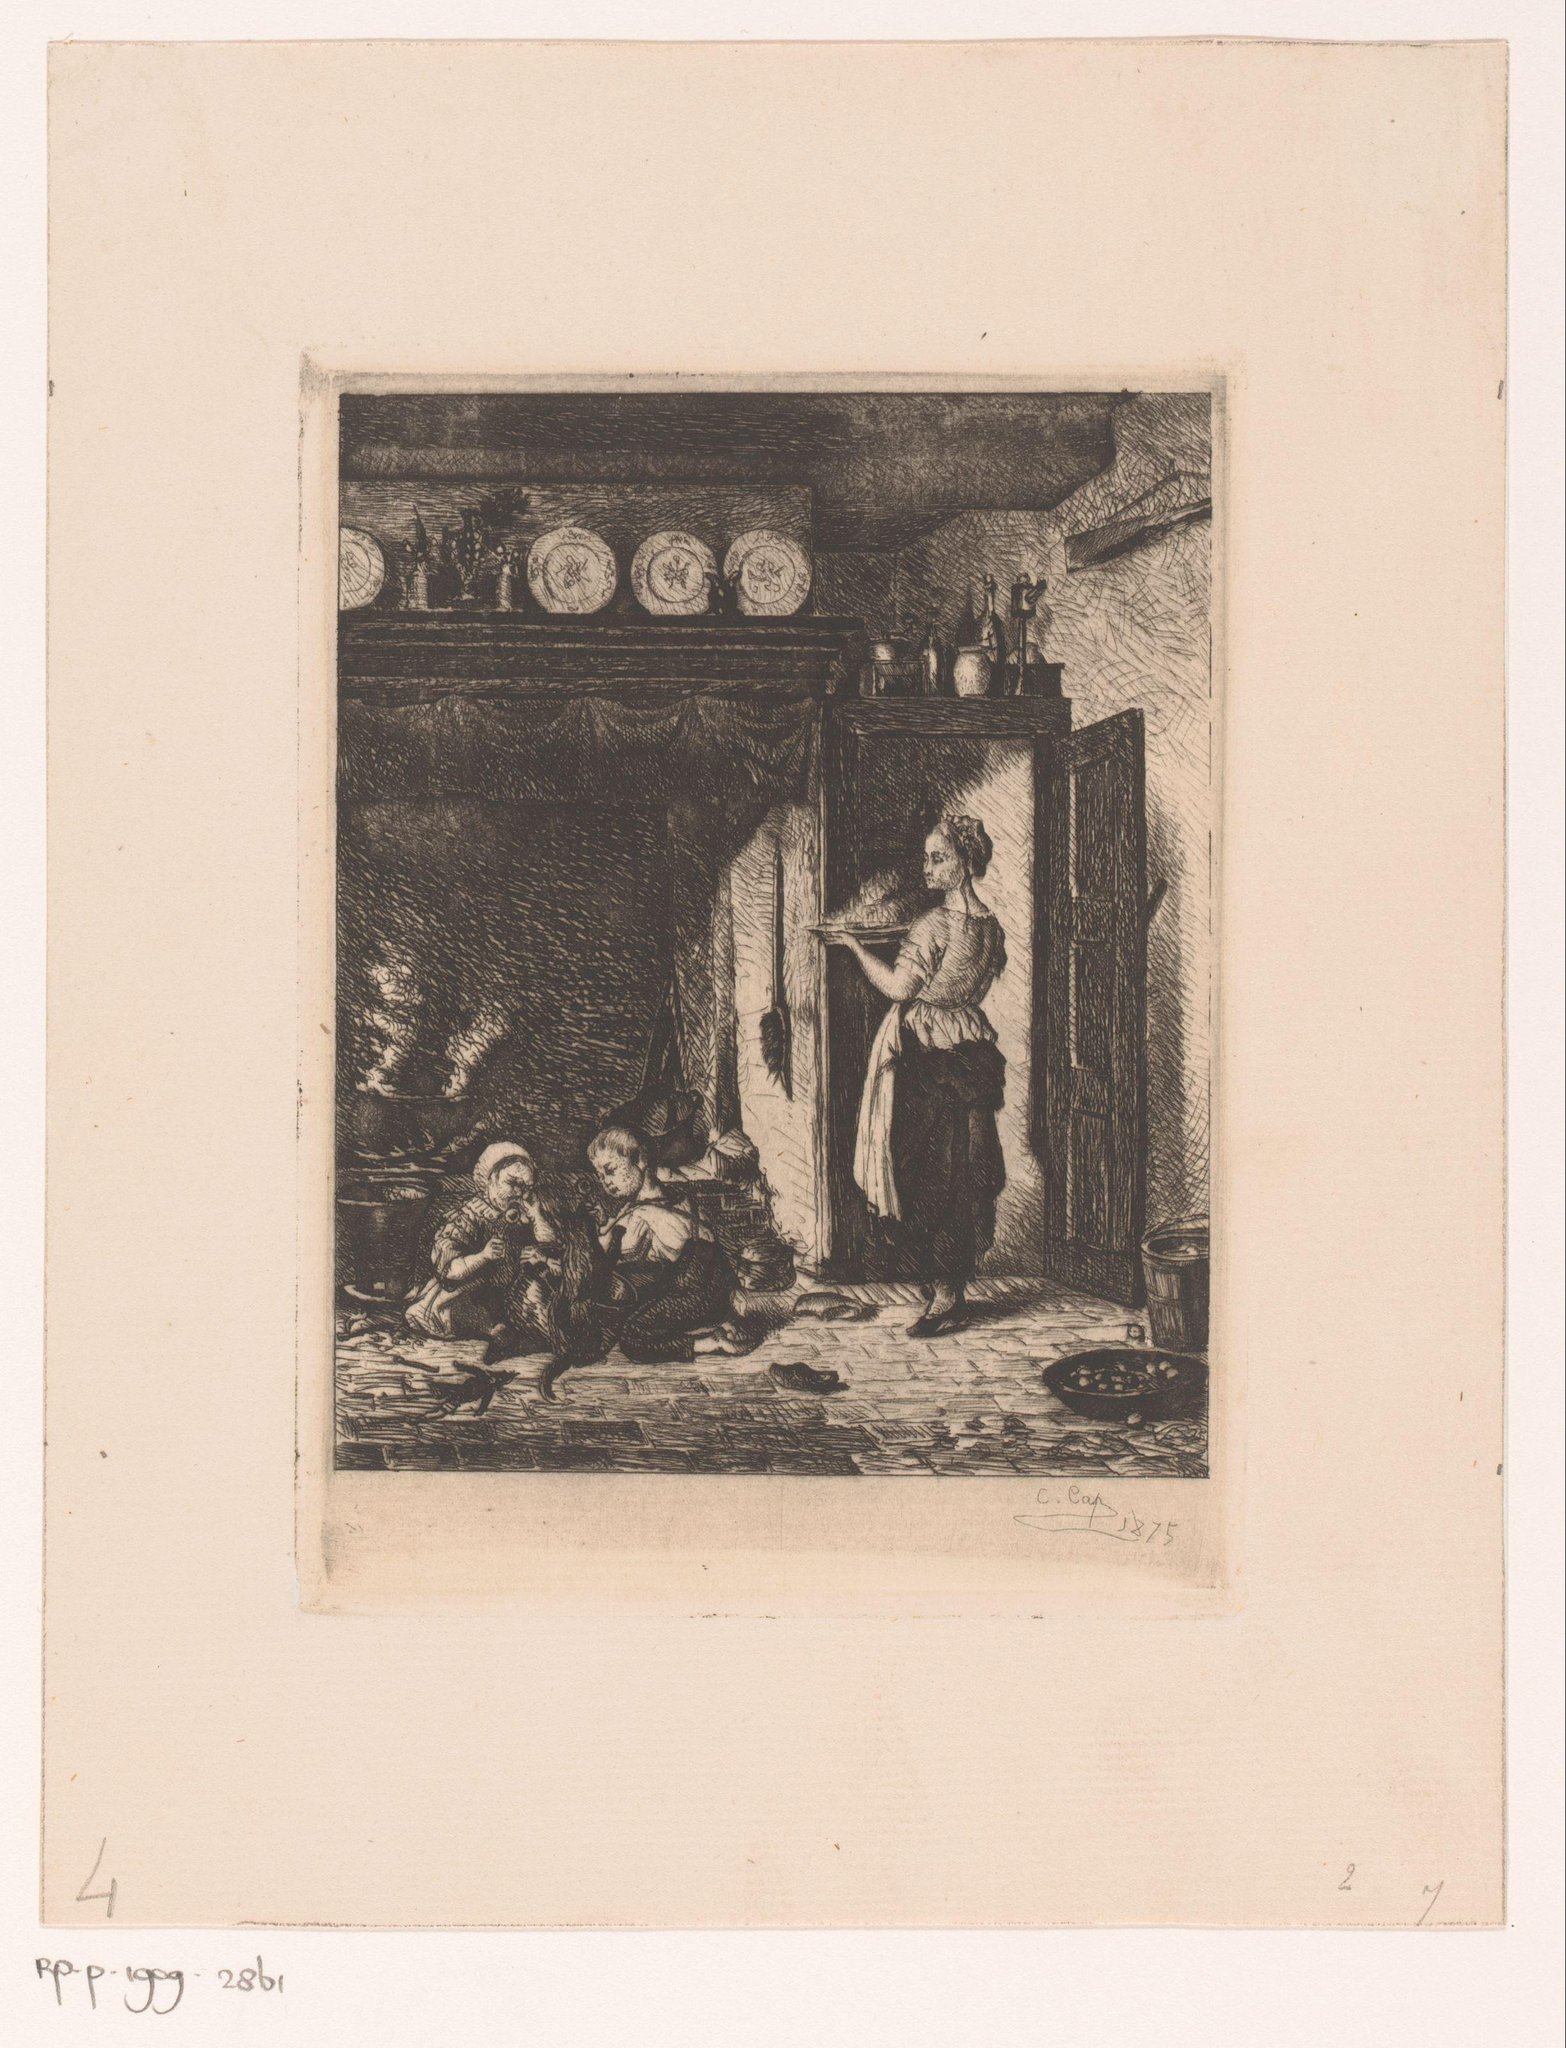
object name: print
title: Moeder met twee spelende kinderen in de keuken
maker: constant aimé marie cap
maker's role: print maker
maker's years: 1842-1915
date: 1875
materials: paper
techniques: drypoint, etching, intaglio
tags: kitchen-interior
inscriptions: collector's mark: Lugt 2228